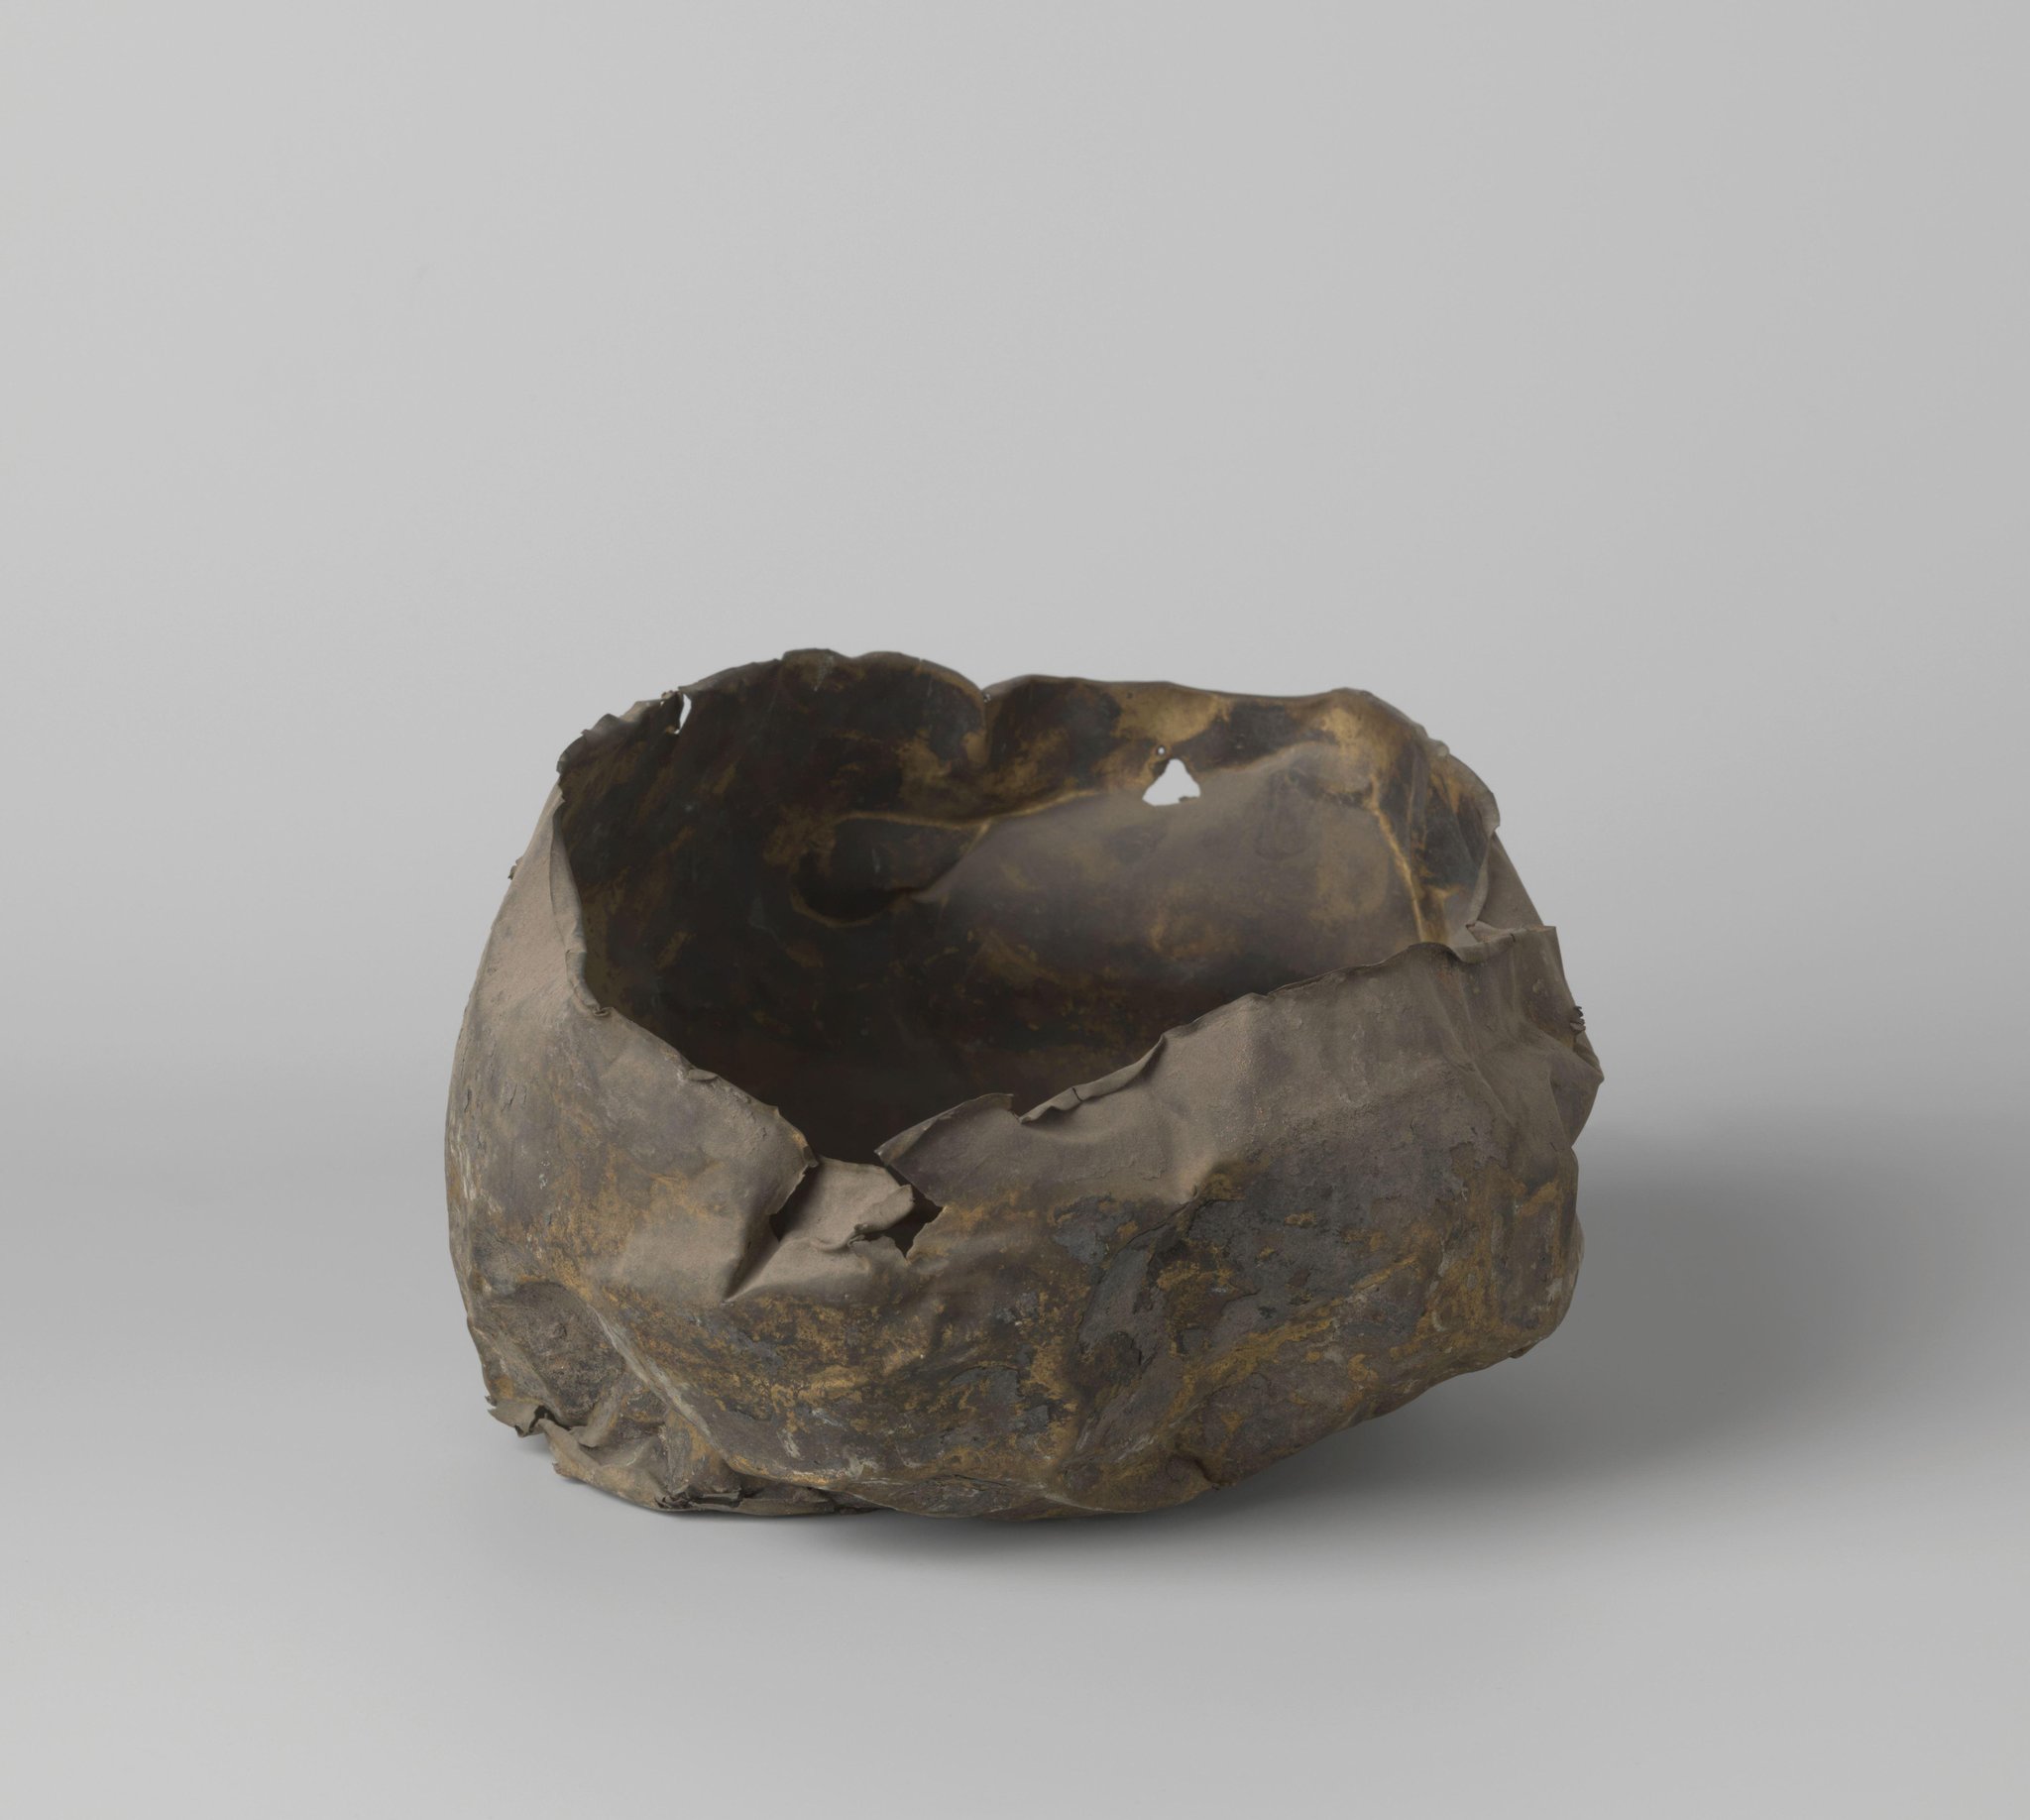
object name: kettle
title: Ketel van messing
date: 1550-1650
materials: brass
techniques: striking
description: Ronde kookketel van messing. De ketel liep van onderen rond. Aan de rand bevinden zich gaten waaraan het hengsel of waaraan een ijzeren rand was bevestigd.